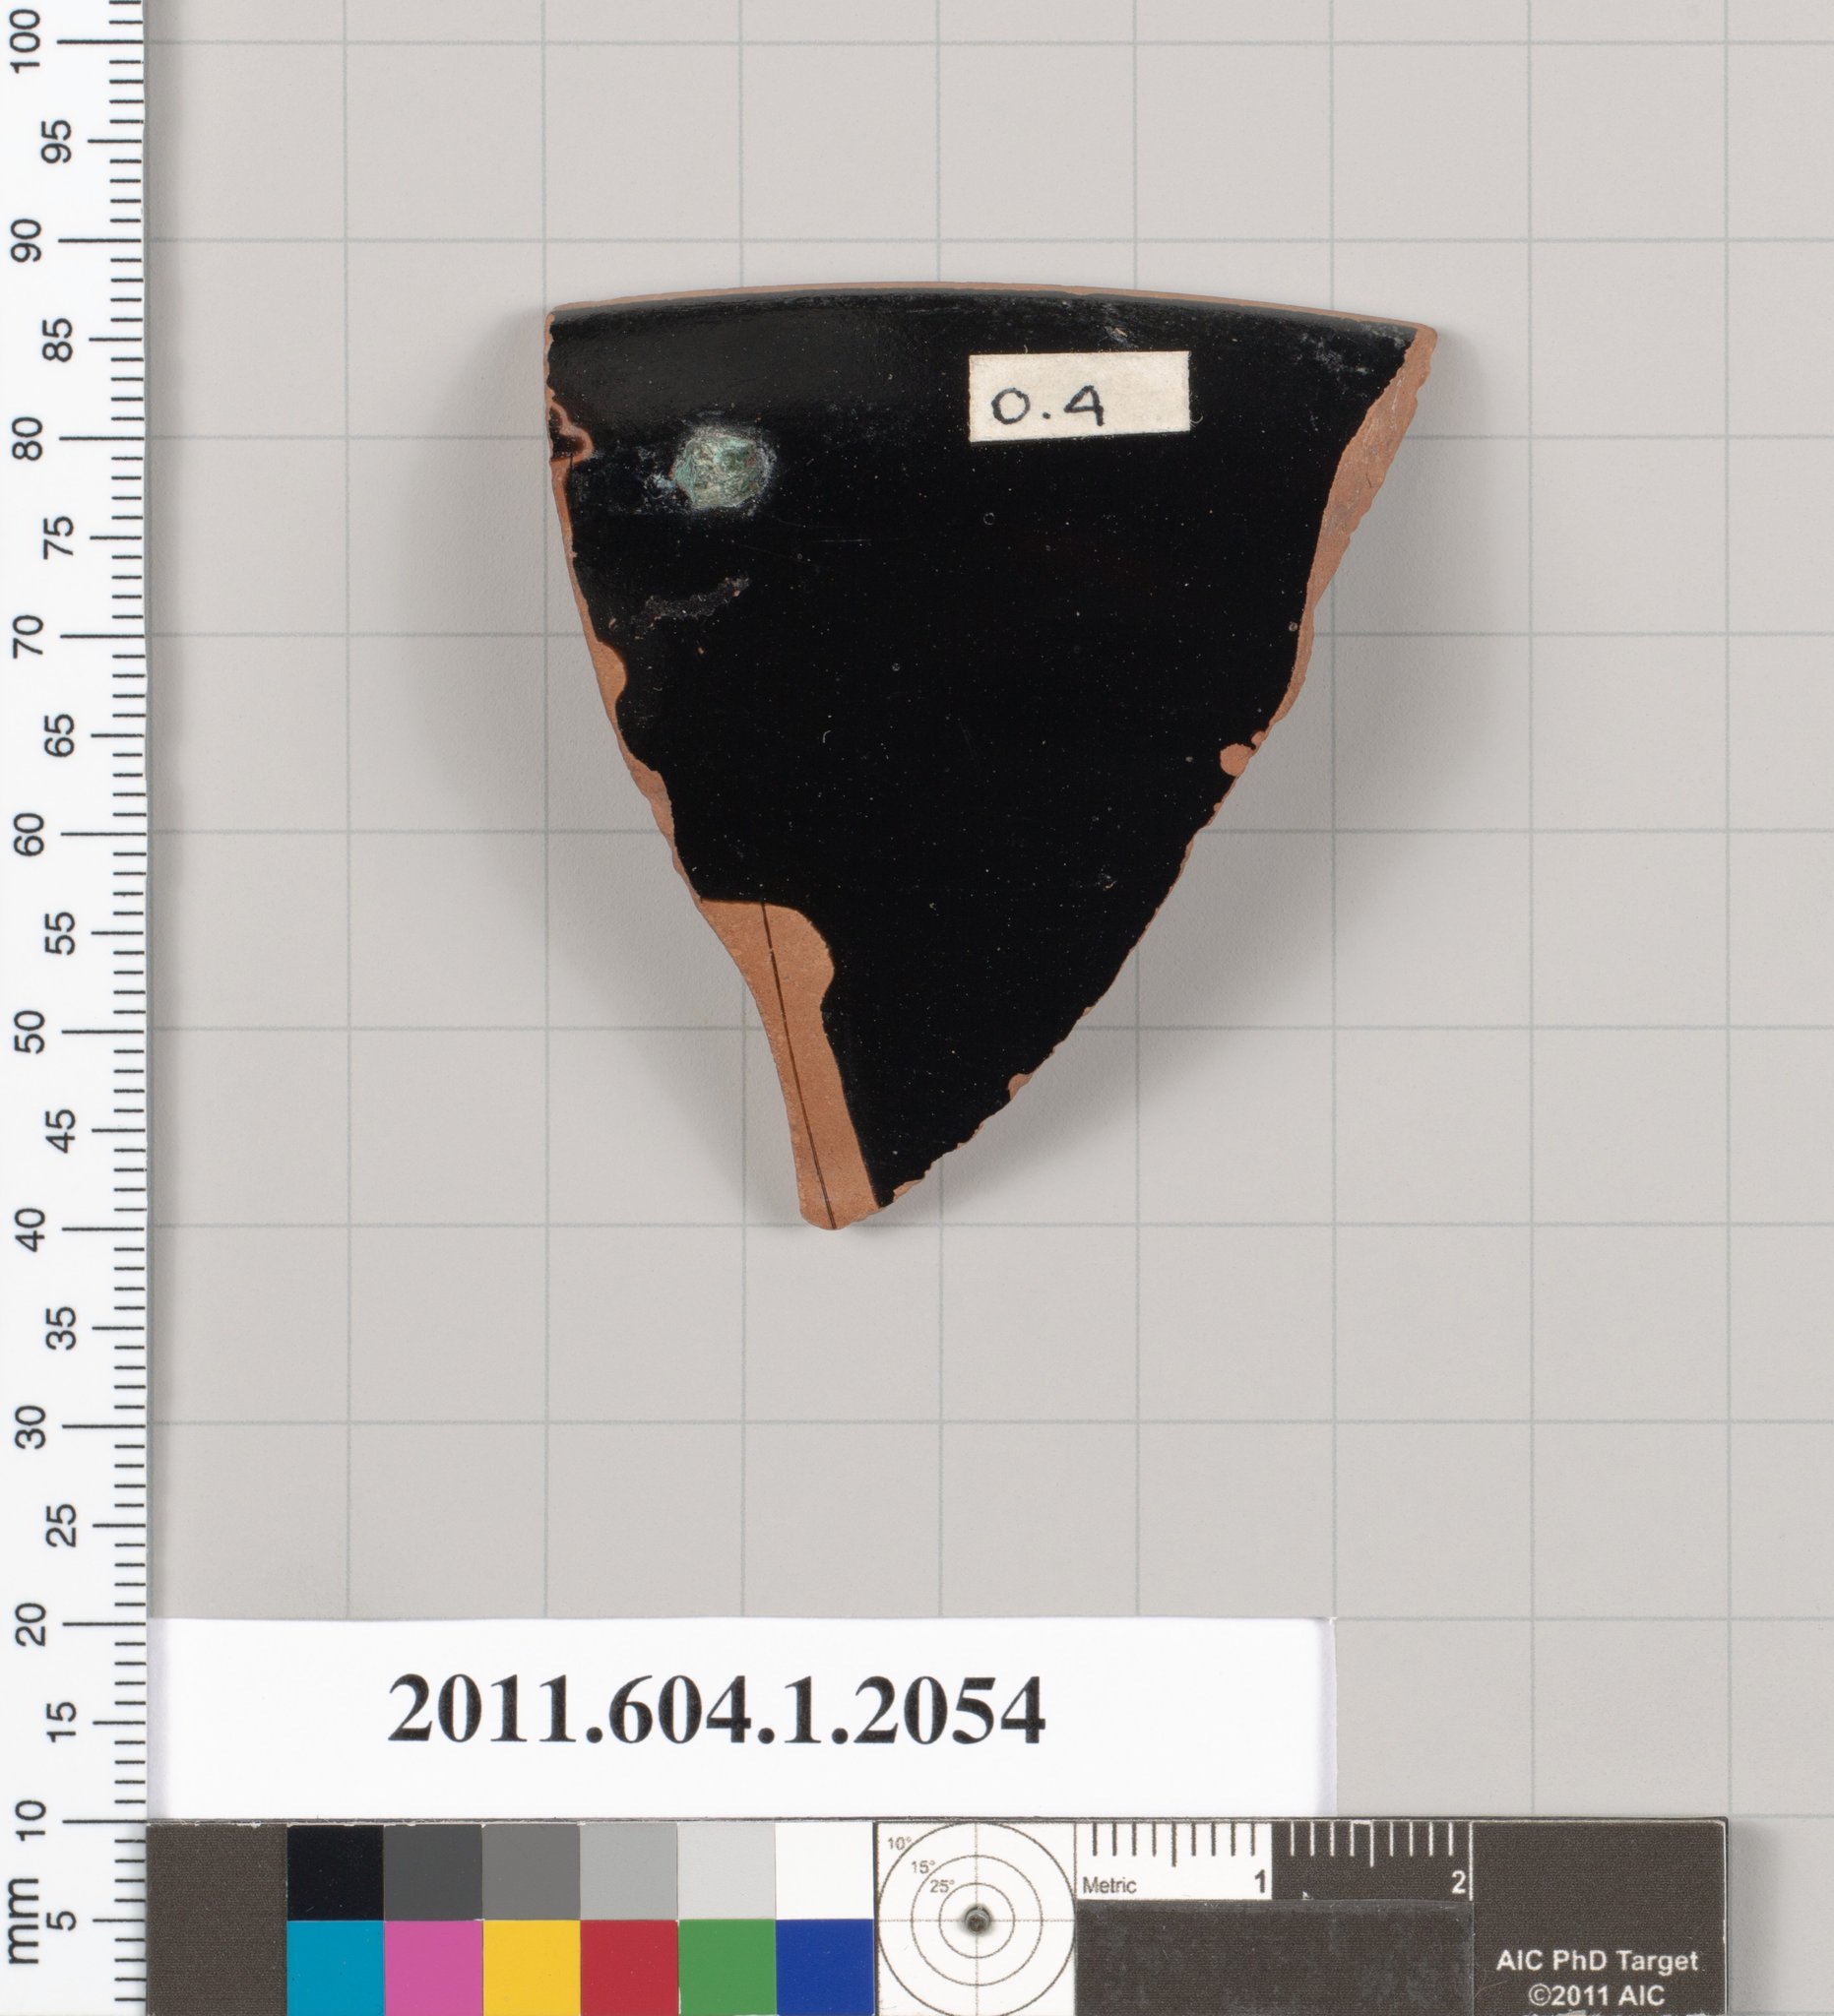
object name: kylix fragment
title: Terracotta rim fragment of a kylix (drinking cup)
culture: greek, attic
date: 475-451 BCE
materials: terracotta